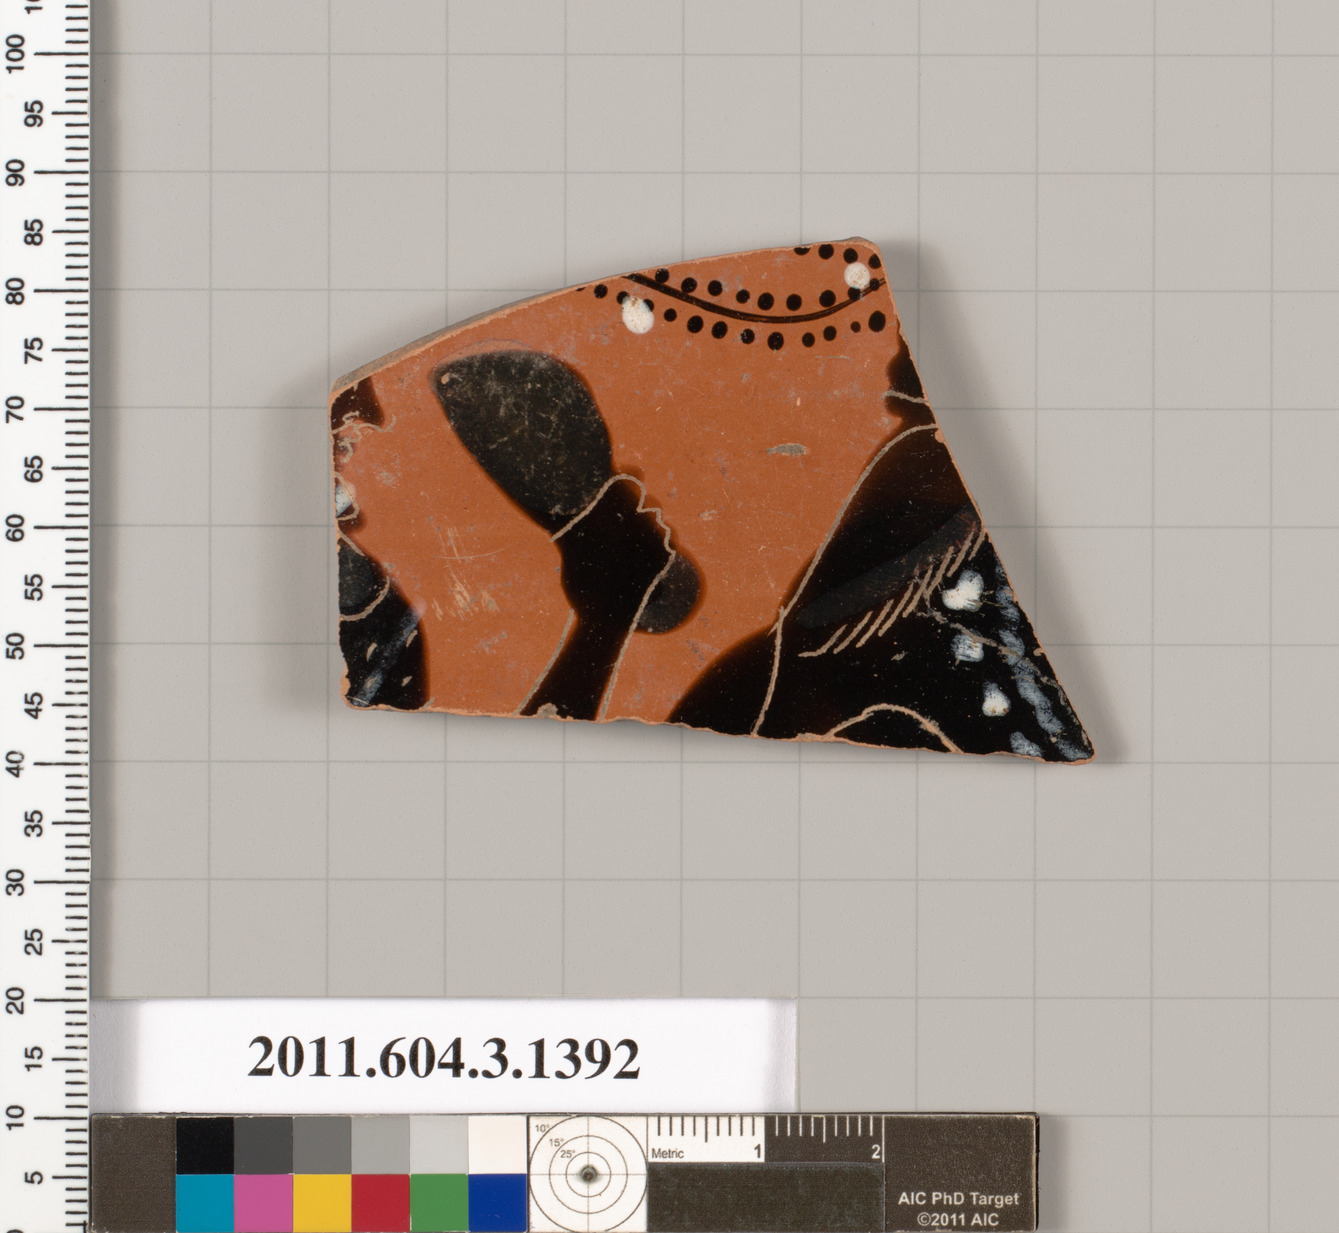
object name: skyphos fragment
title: Terracotta fragment of a skyphos (deep drinking cup)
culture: greek, attic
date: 534-468 BCE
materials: terracotta